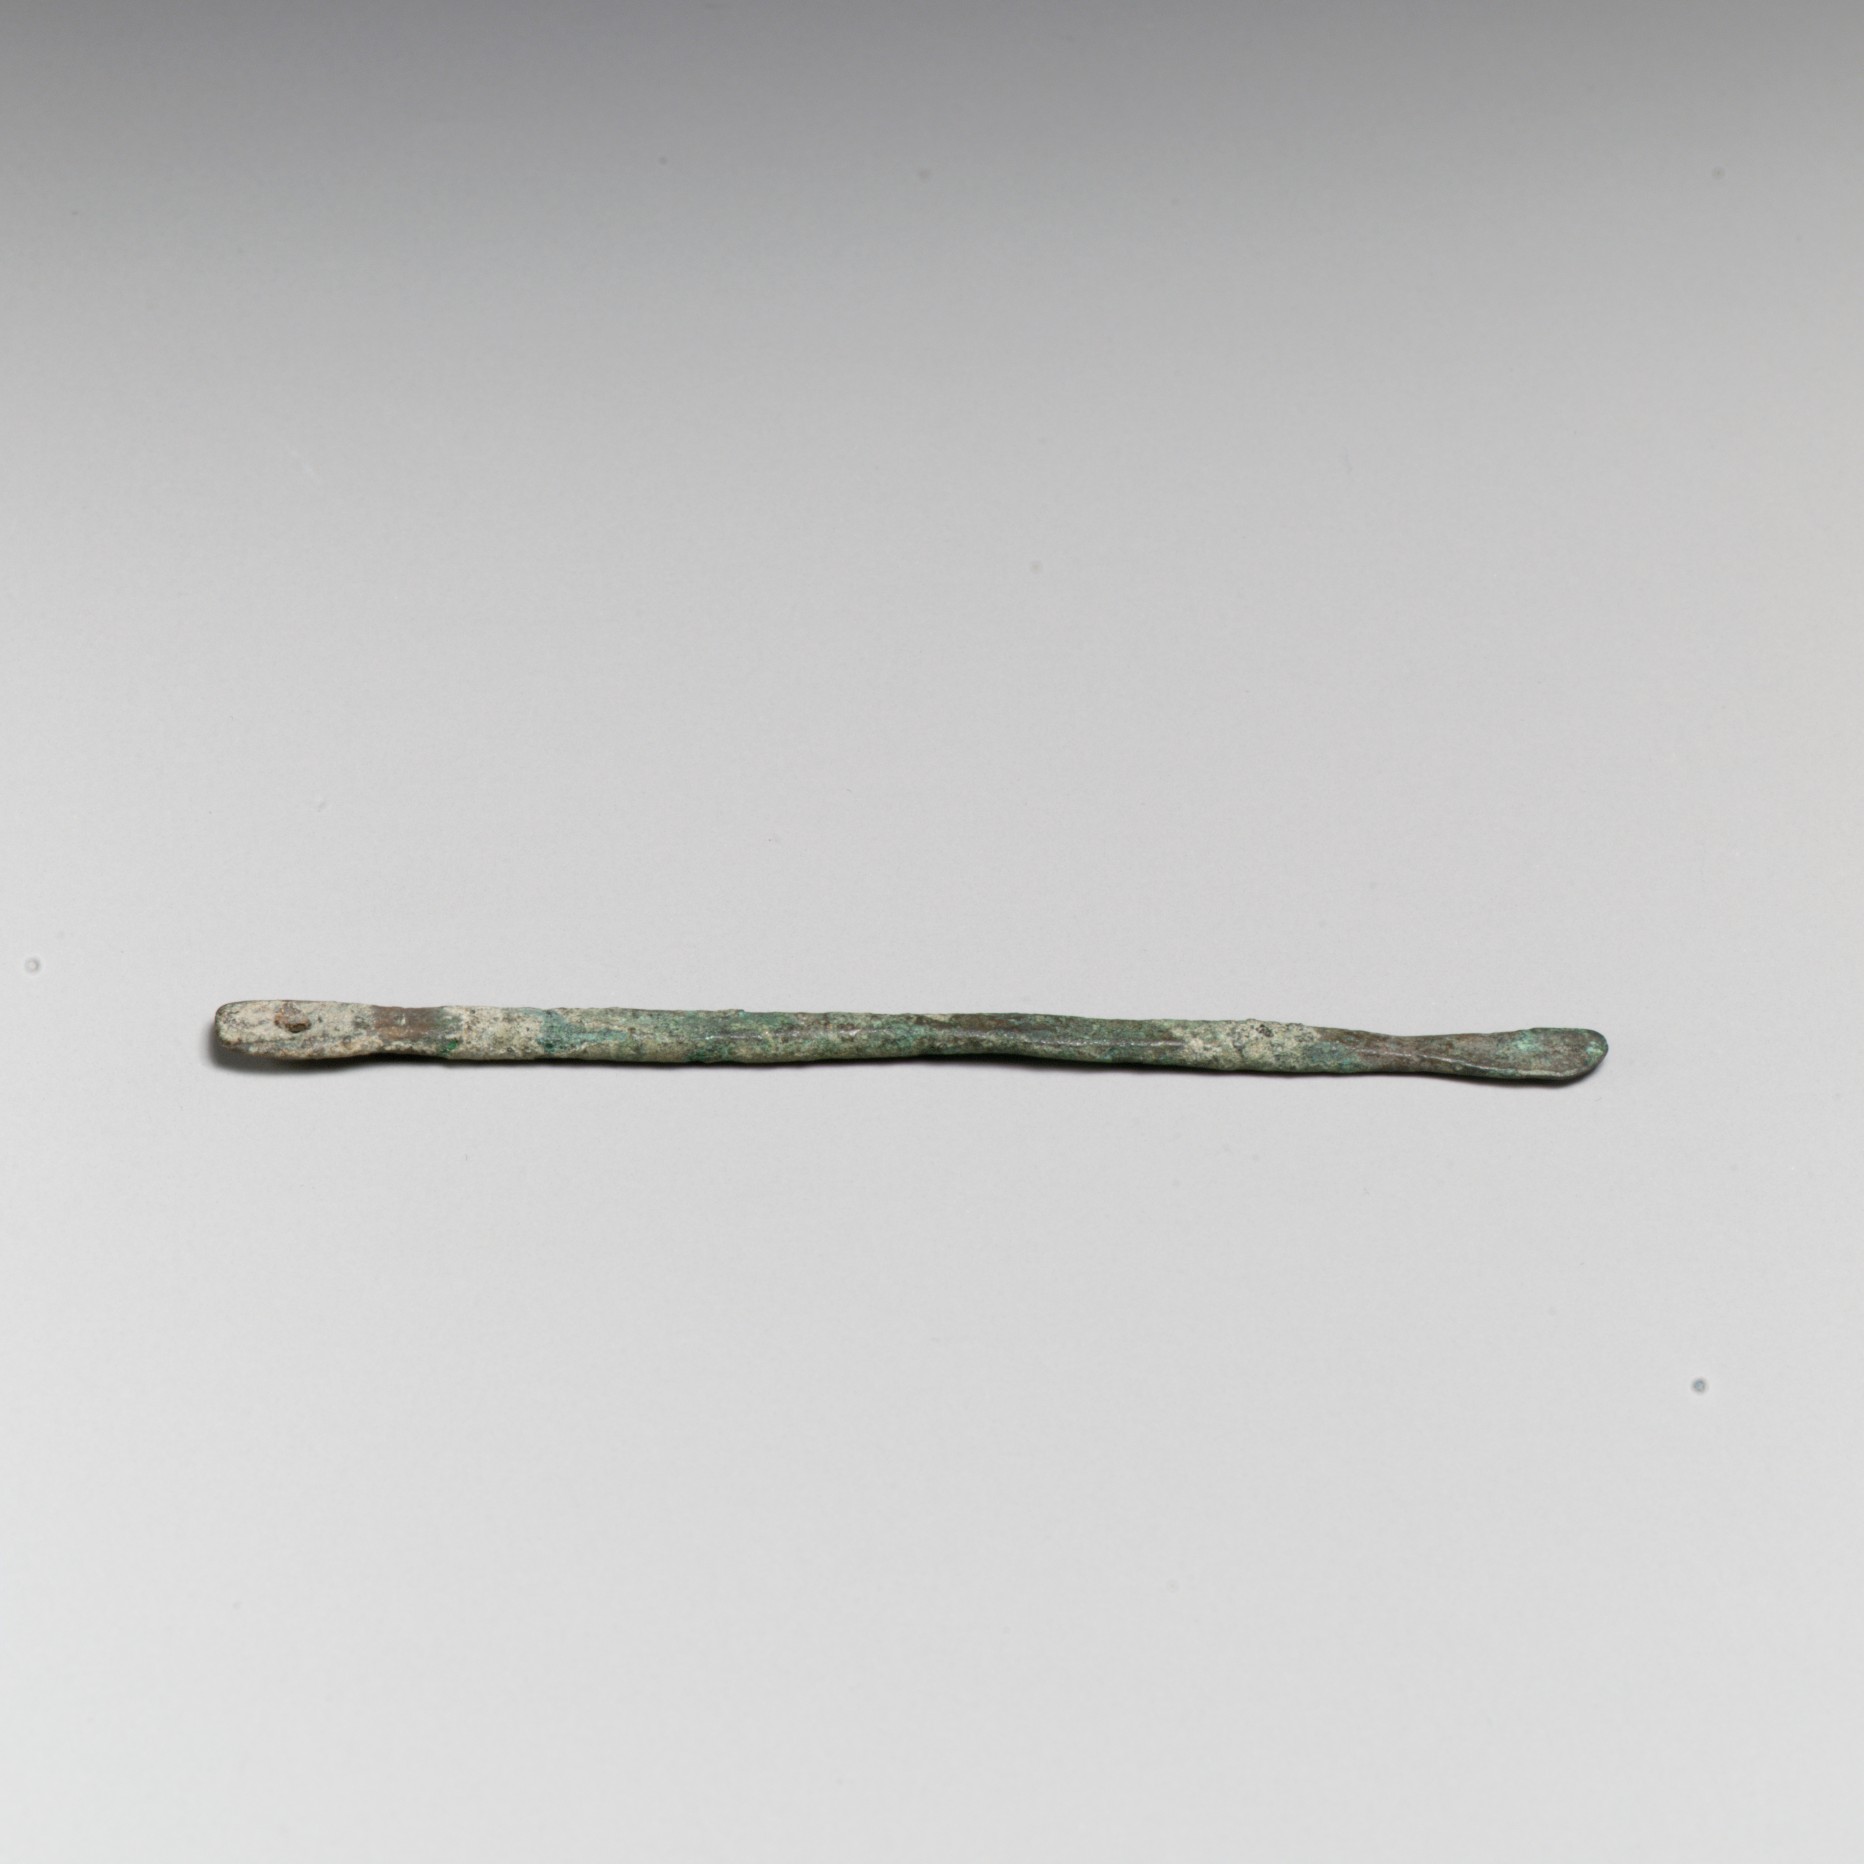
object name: tool nail cleaner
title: Tool ? Nail cleaner ?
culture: roman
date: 670 BCE-330 CE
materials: bronze